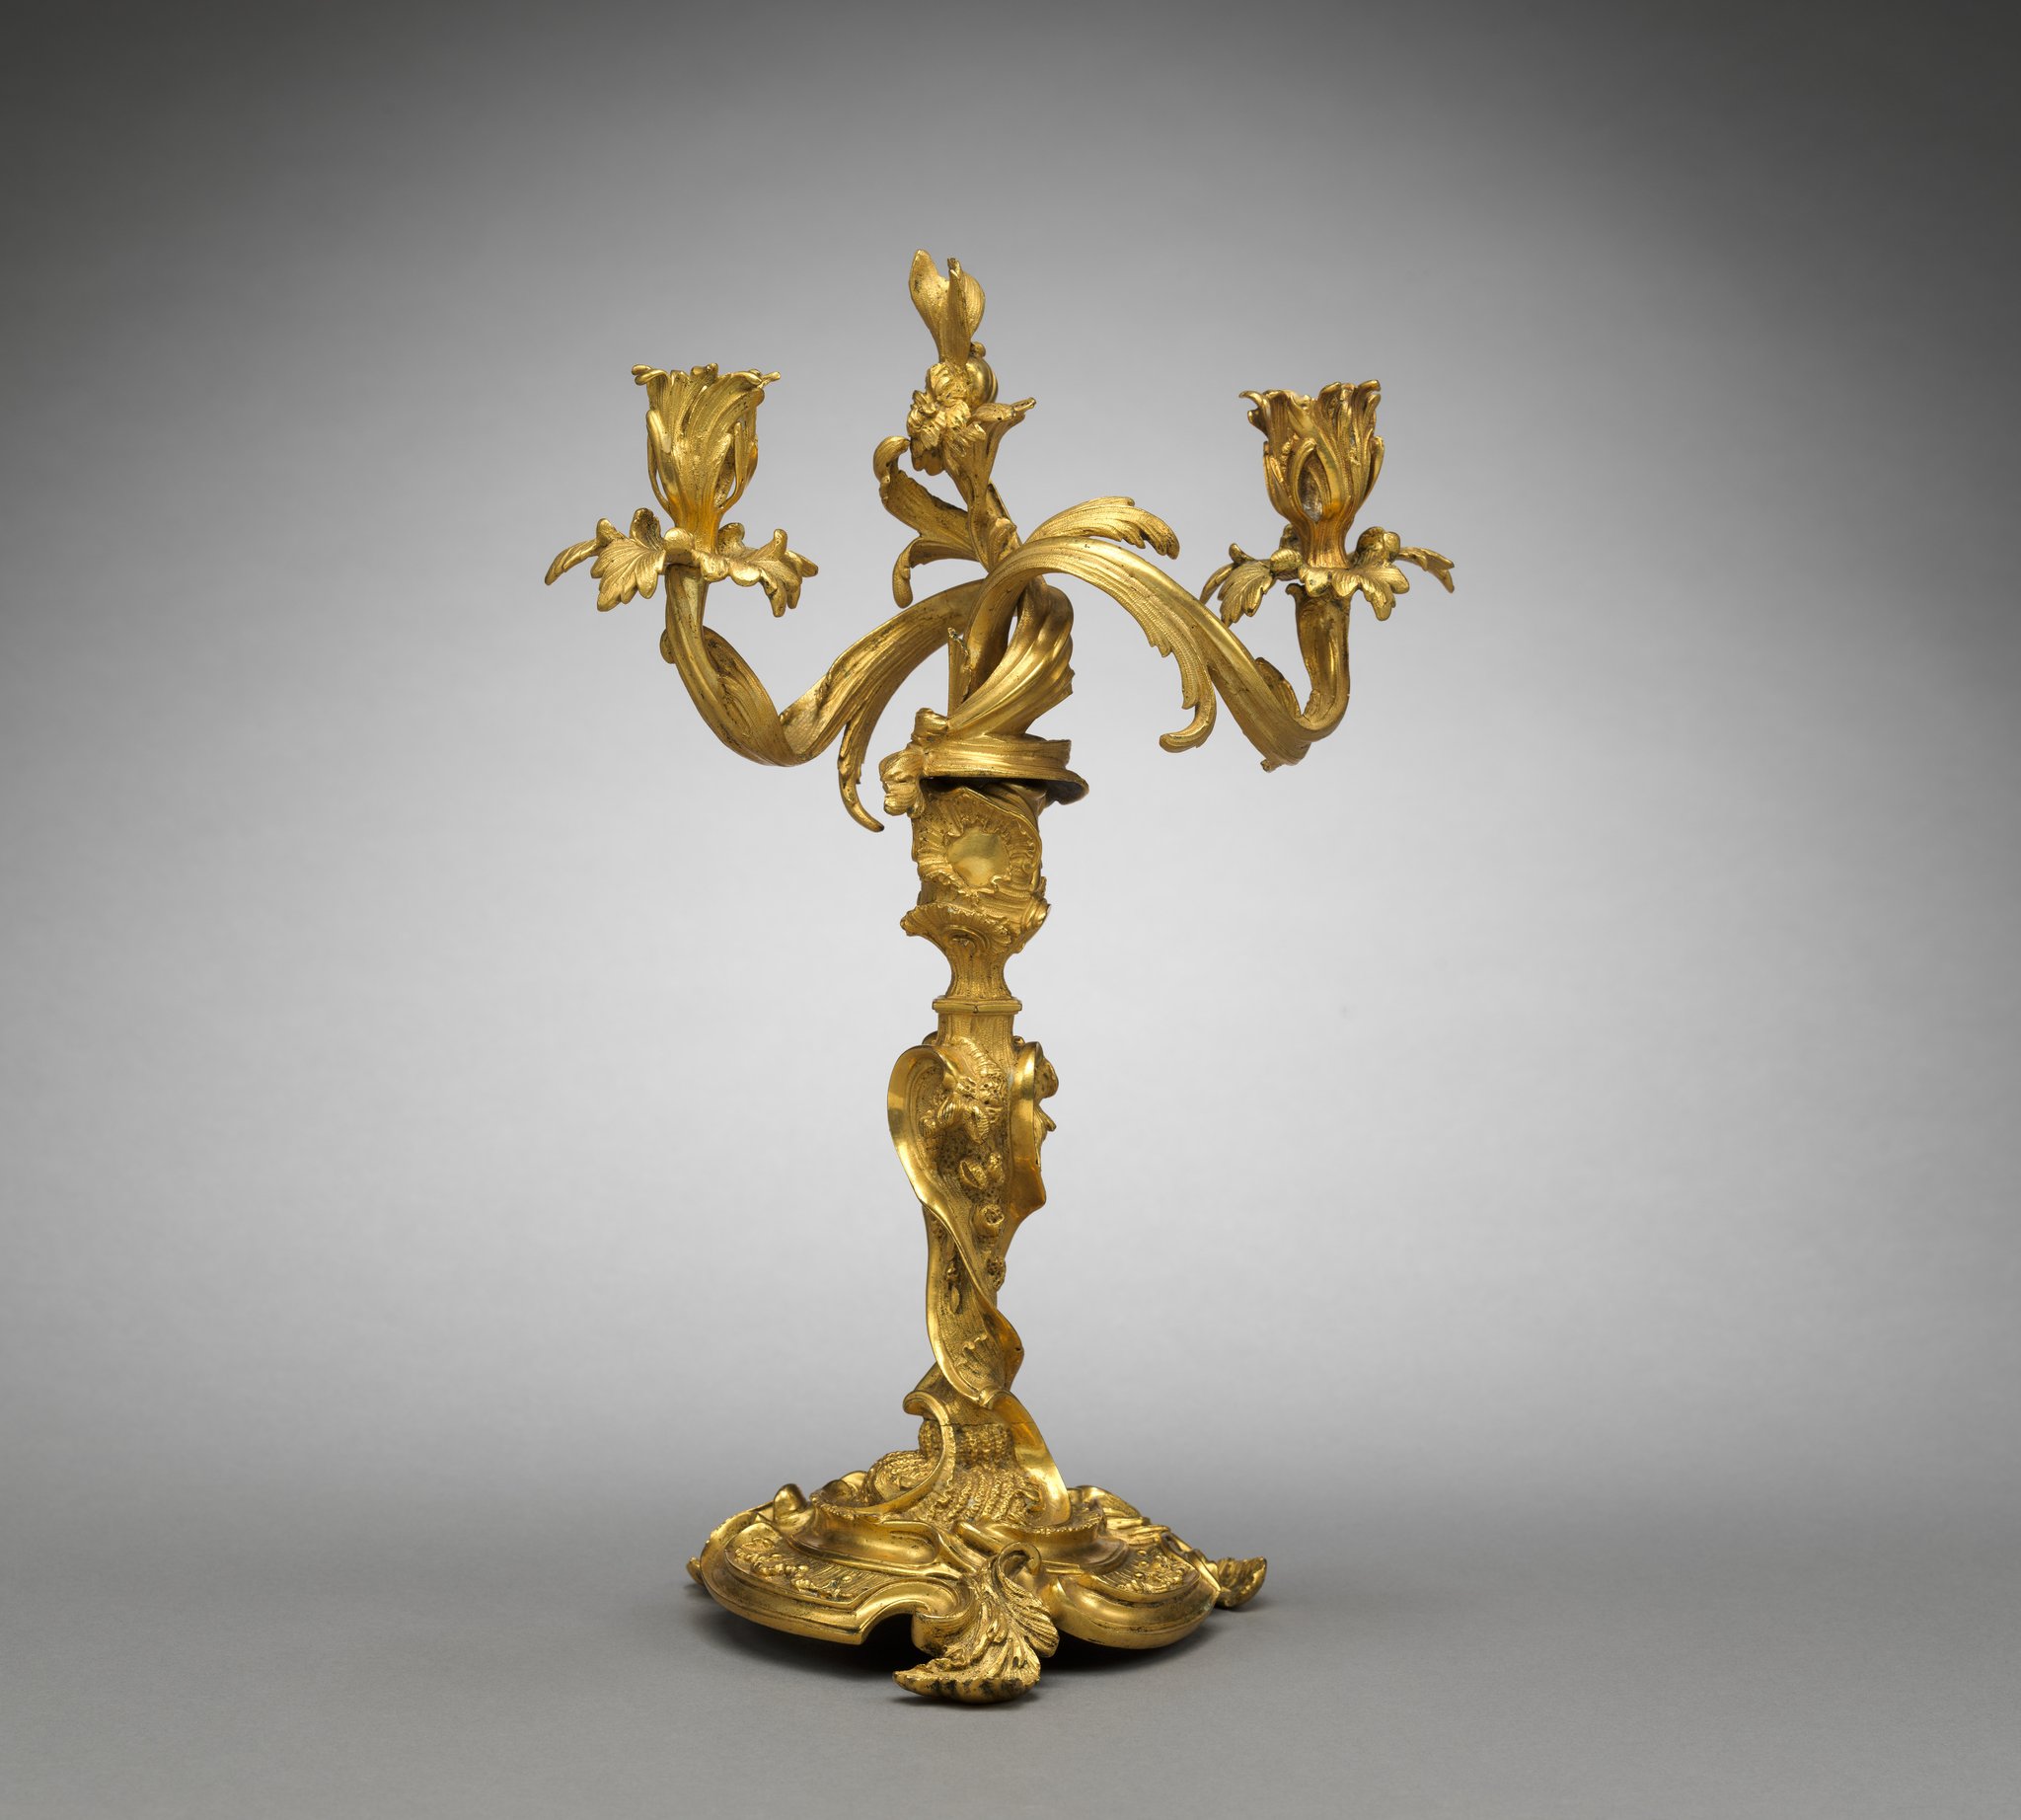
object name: candlestick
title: Candlestick with Two Branches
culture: french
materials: gilt bronze